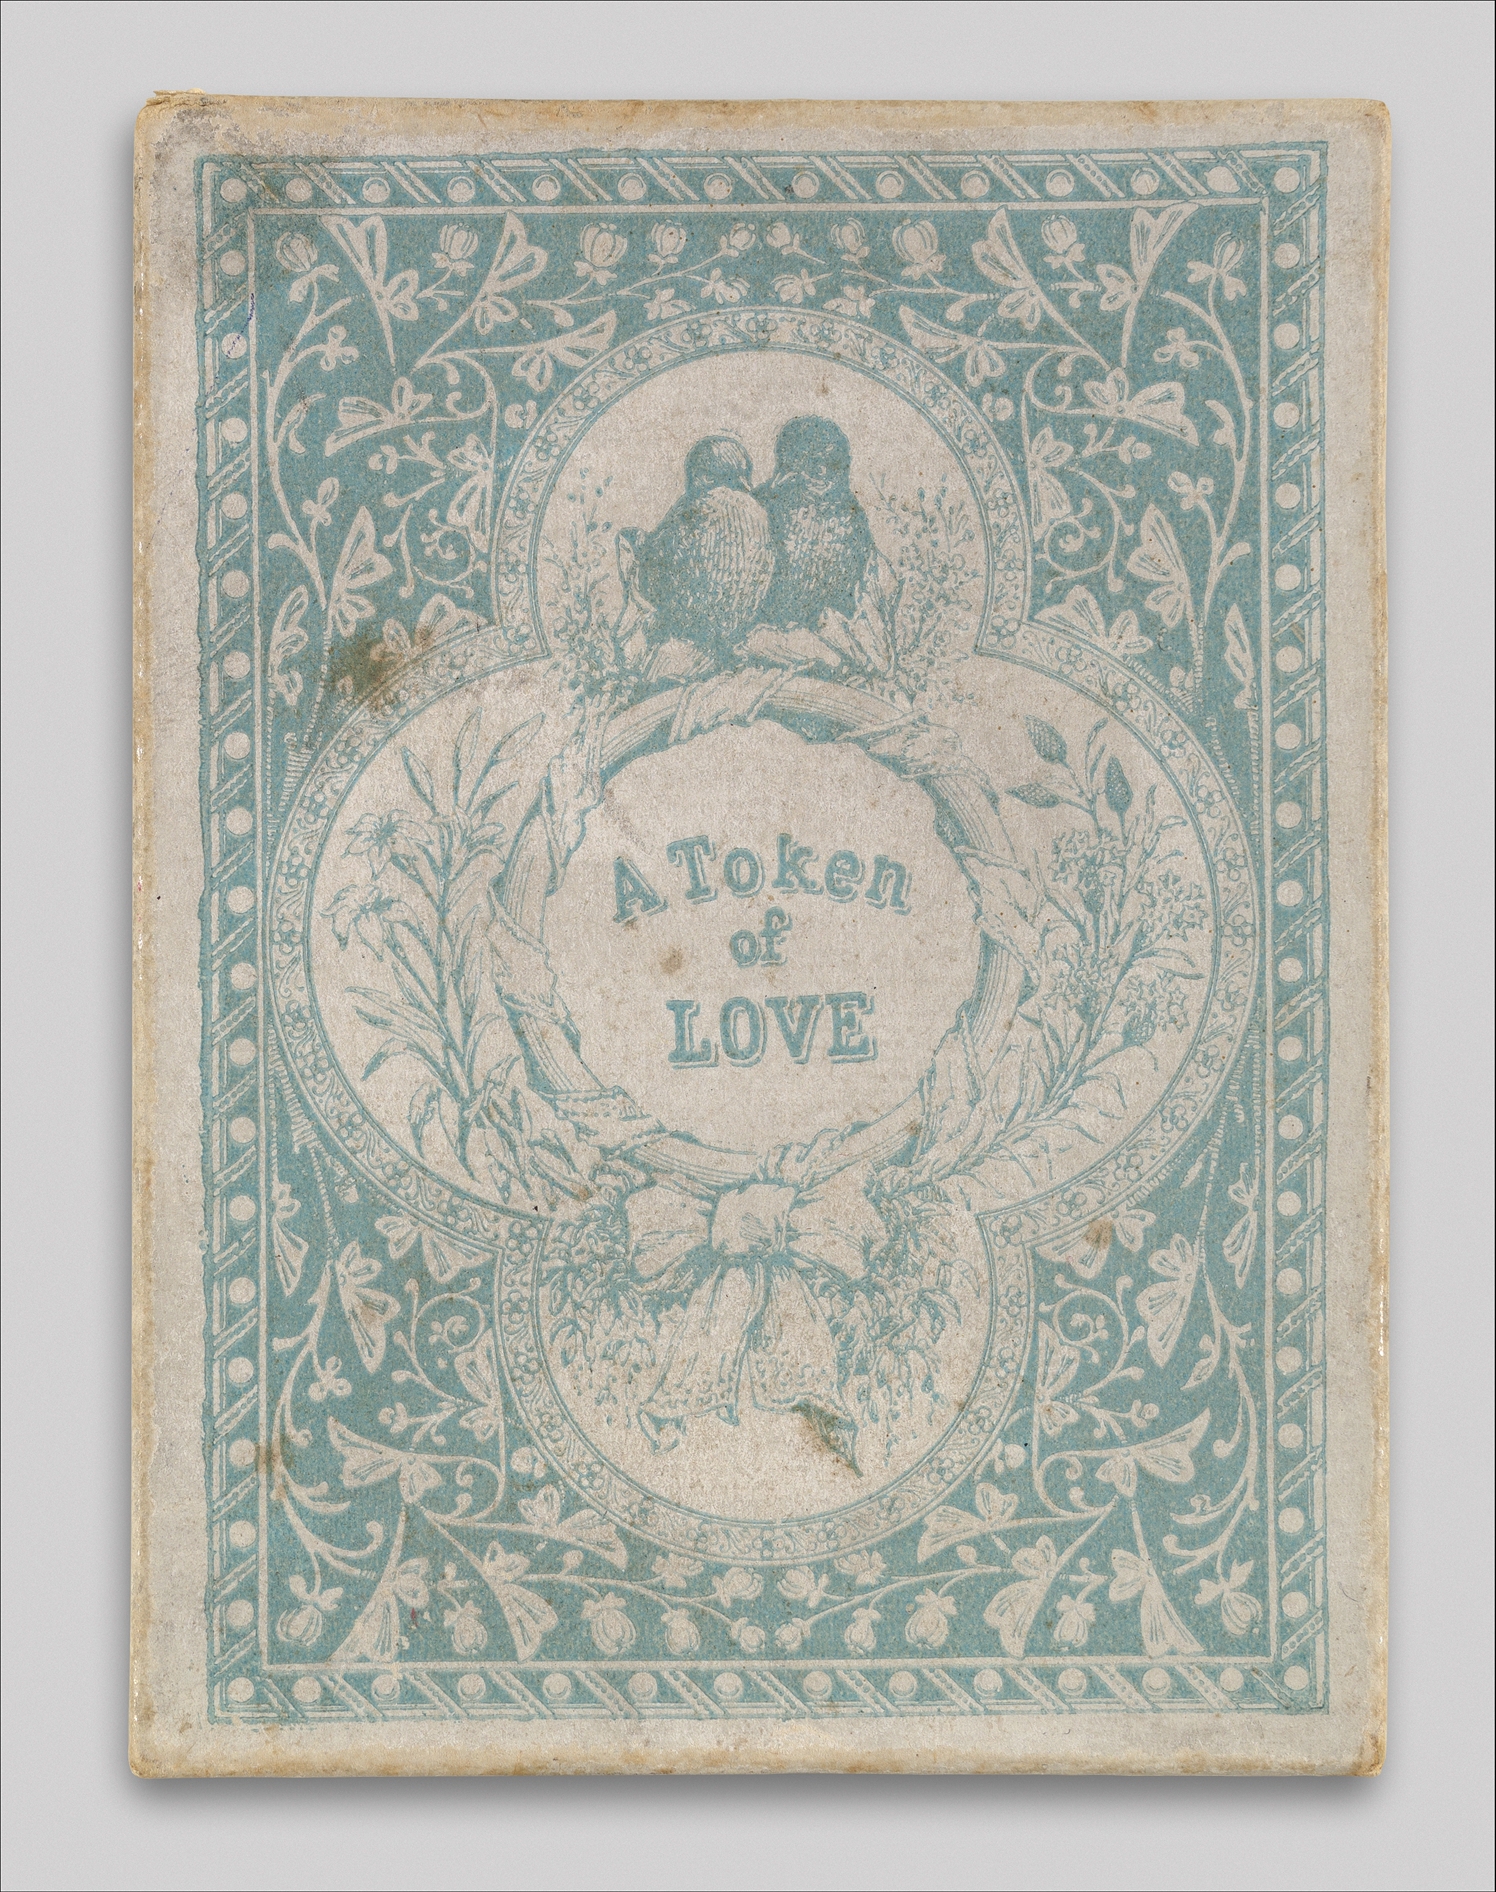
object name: card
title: Boxed Valentine's Day Card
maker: anonymous, british, late 18th century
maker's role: artist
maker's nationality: british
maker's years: 1750-1800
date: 1850-1899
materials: paper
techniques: cutting, lithograph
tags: birds,flowers,leaves